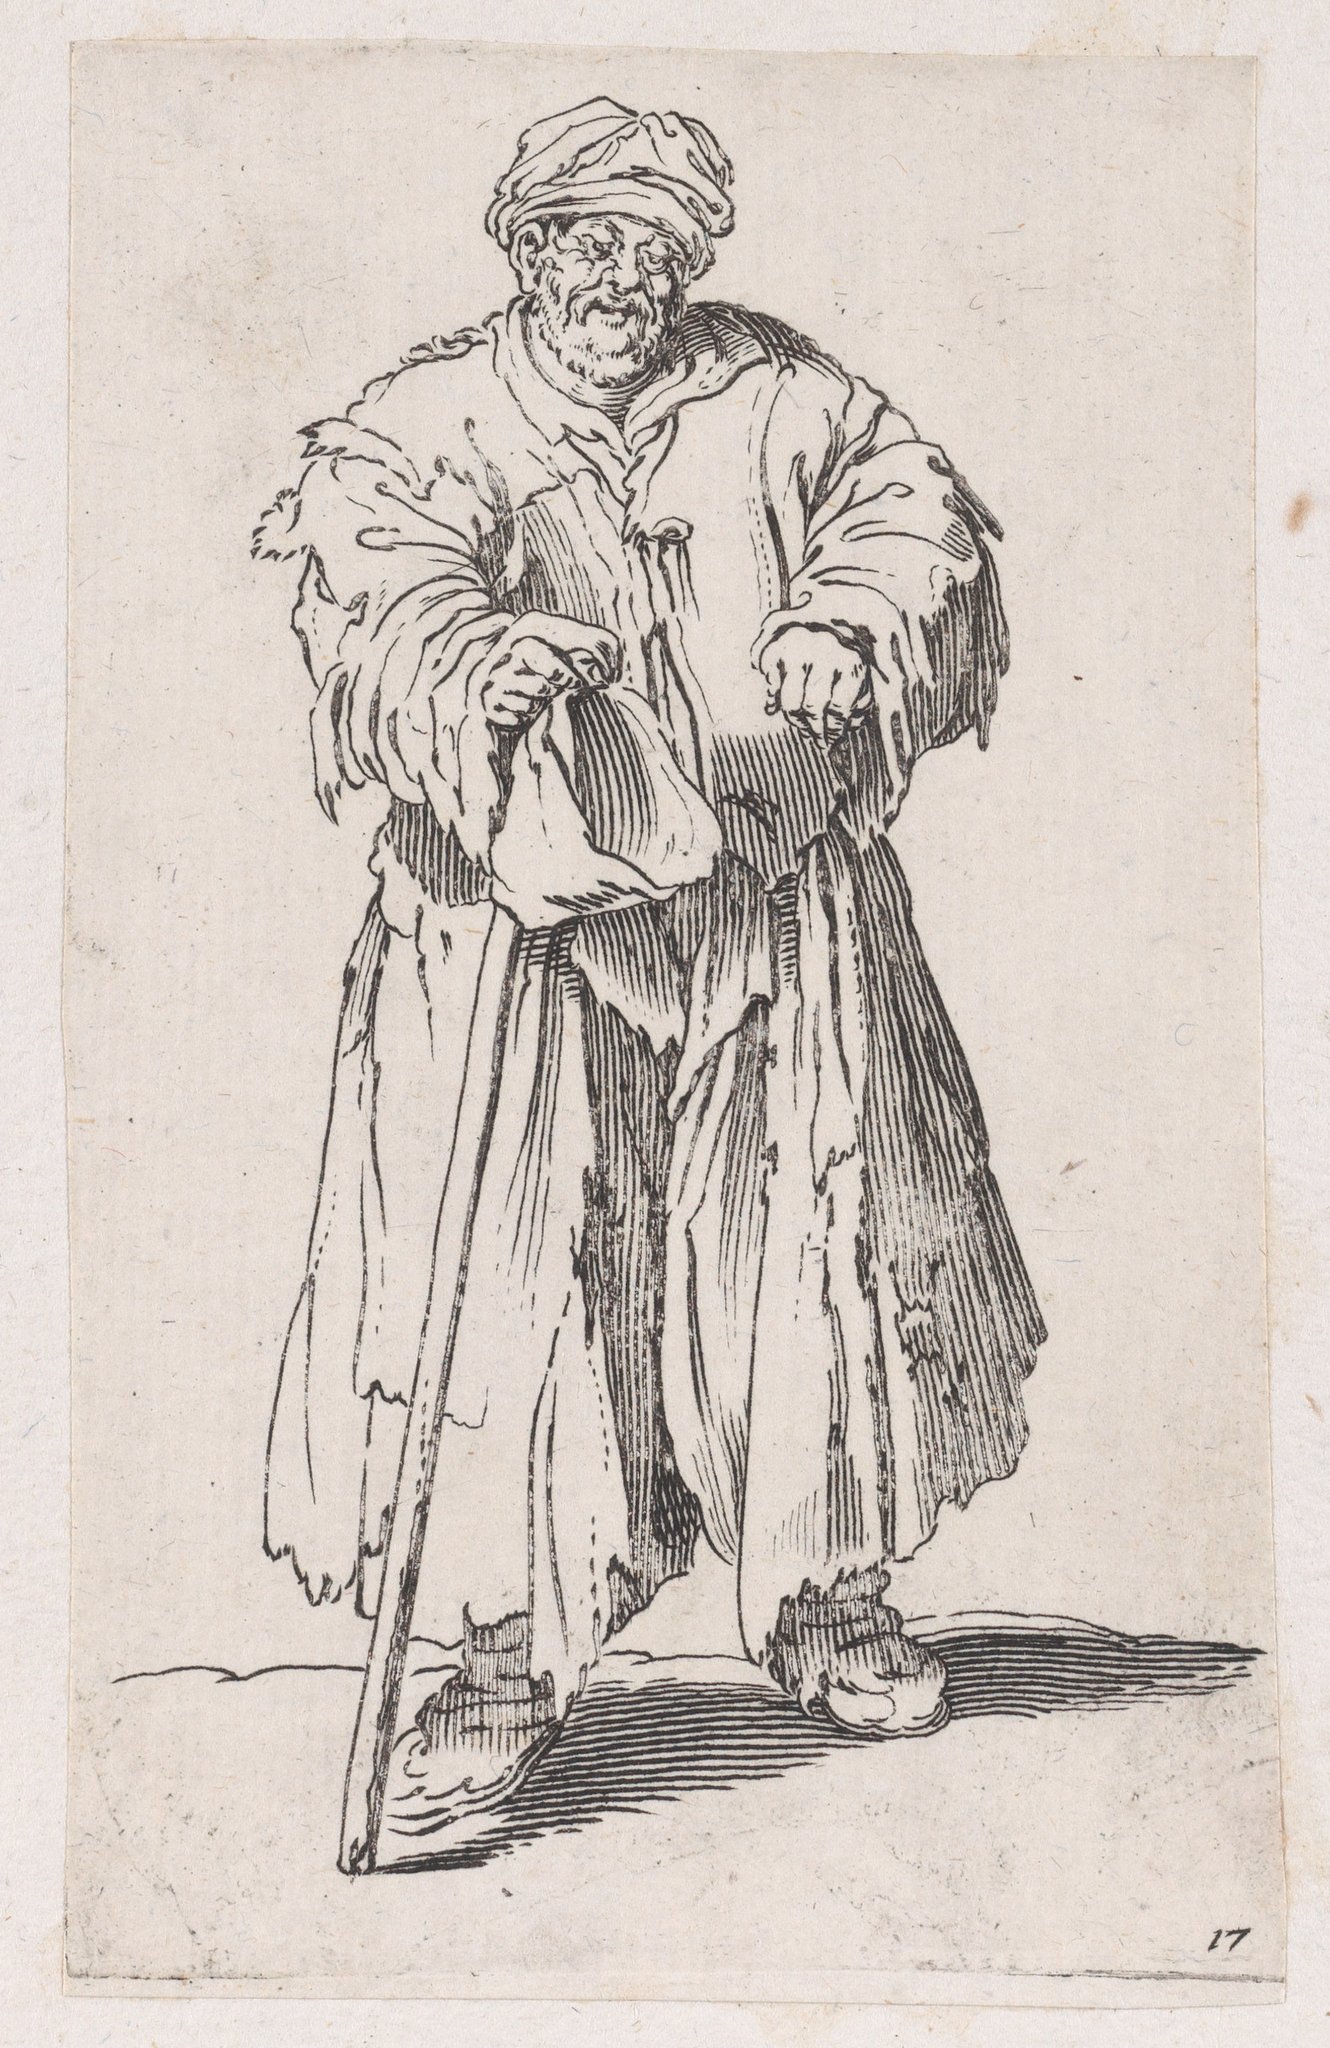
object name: print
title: Reverse Copy of Le Mendiant Obèse aux Yeux Baissés (The Obese Beggar with Lowered Eyes), from Les Gueux suite appelée aussi Les Mendiants, Les Baroni, ou Les Barons (The Beggars, also called the Barons)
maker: Anonymous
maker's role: artist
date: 1601-1700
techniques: etching